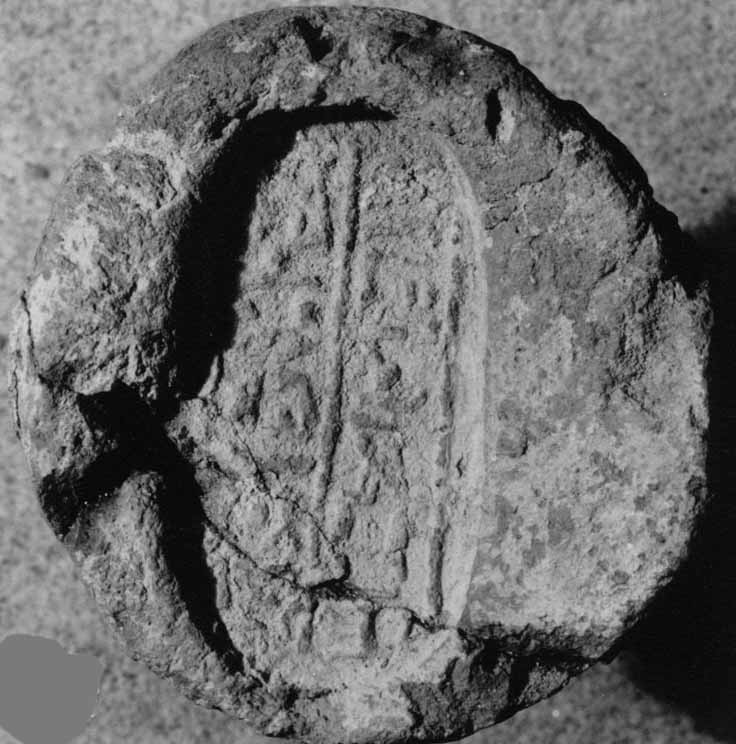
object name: cone, tjay, oval impression, chief of the merchant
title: Funerary Cone of the Chief of the Merchants Tjay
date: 1550-1295 BCE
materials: pottery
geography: egypt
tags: hieroglyphs